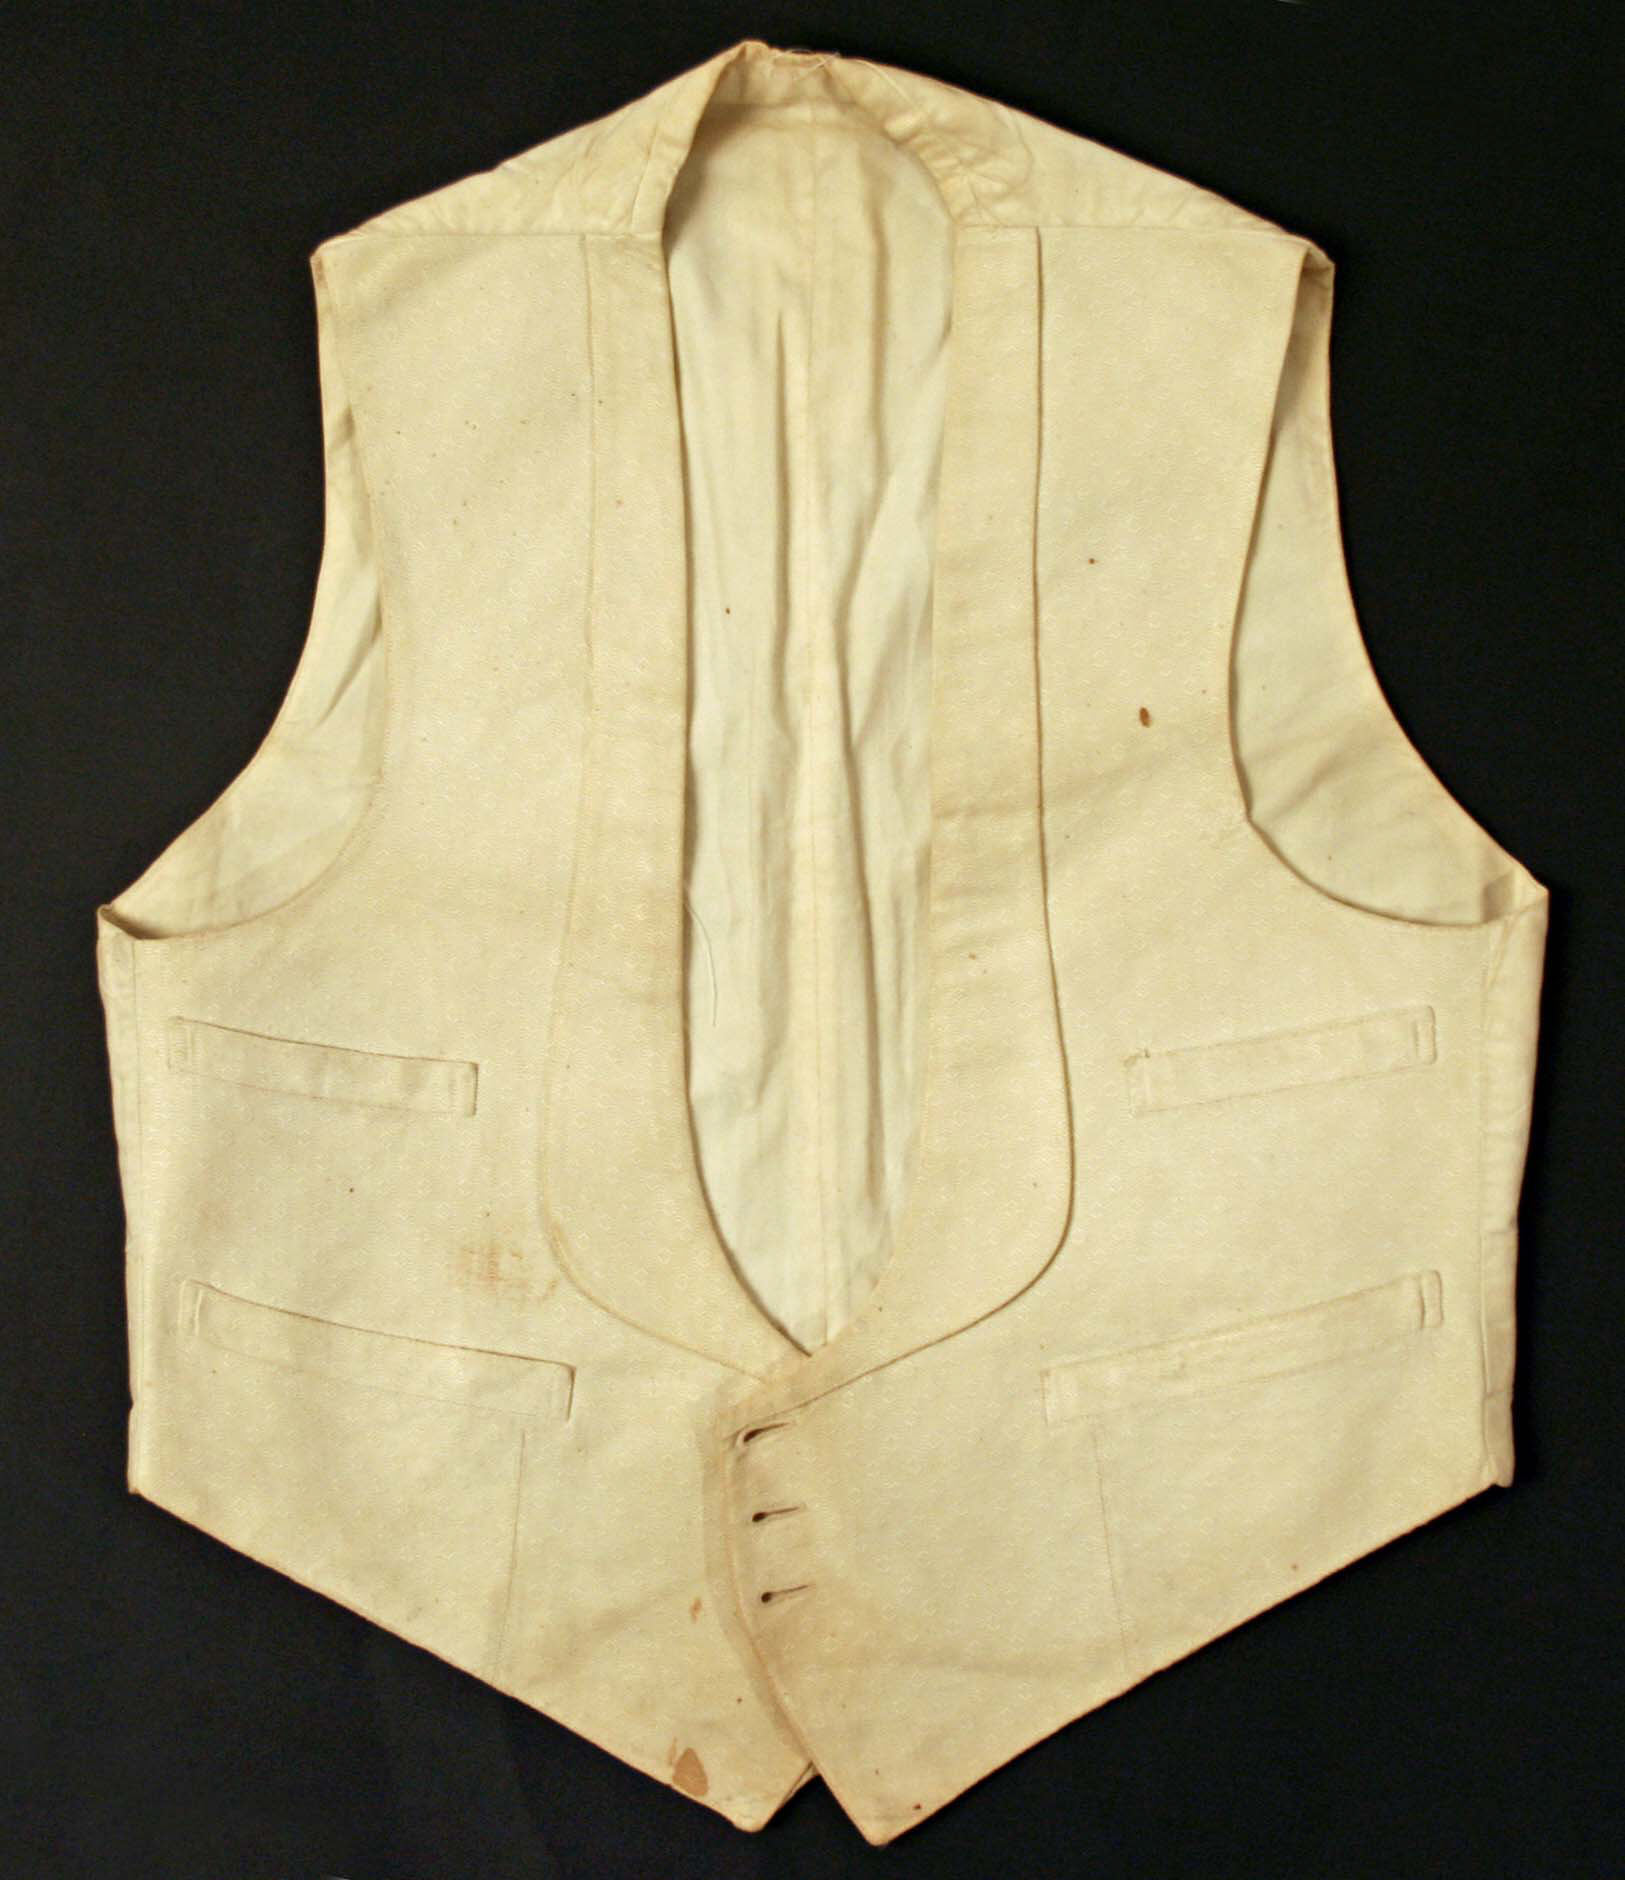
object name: vest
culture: american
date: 1901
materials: cotton